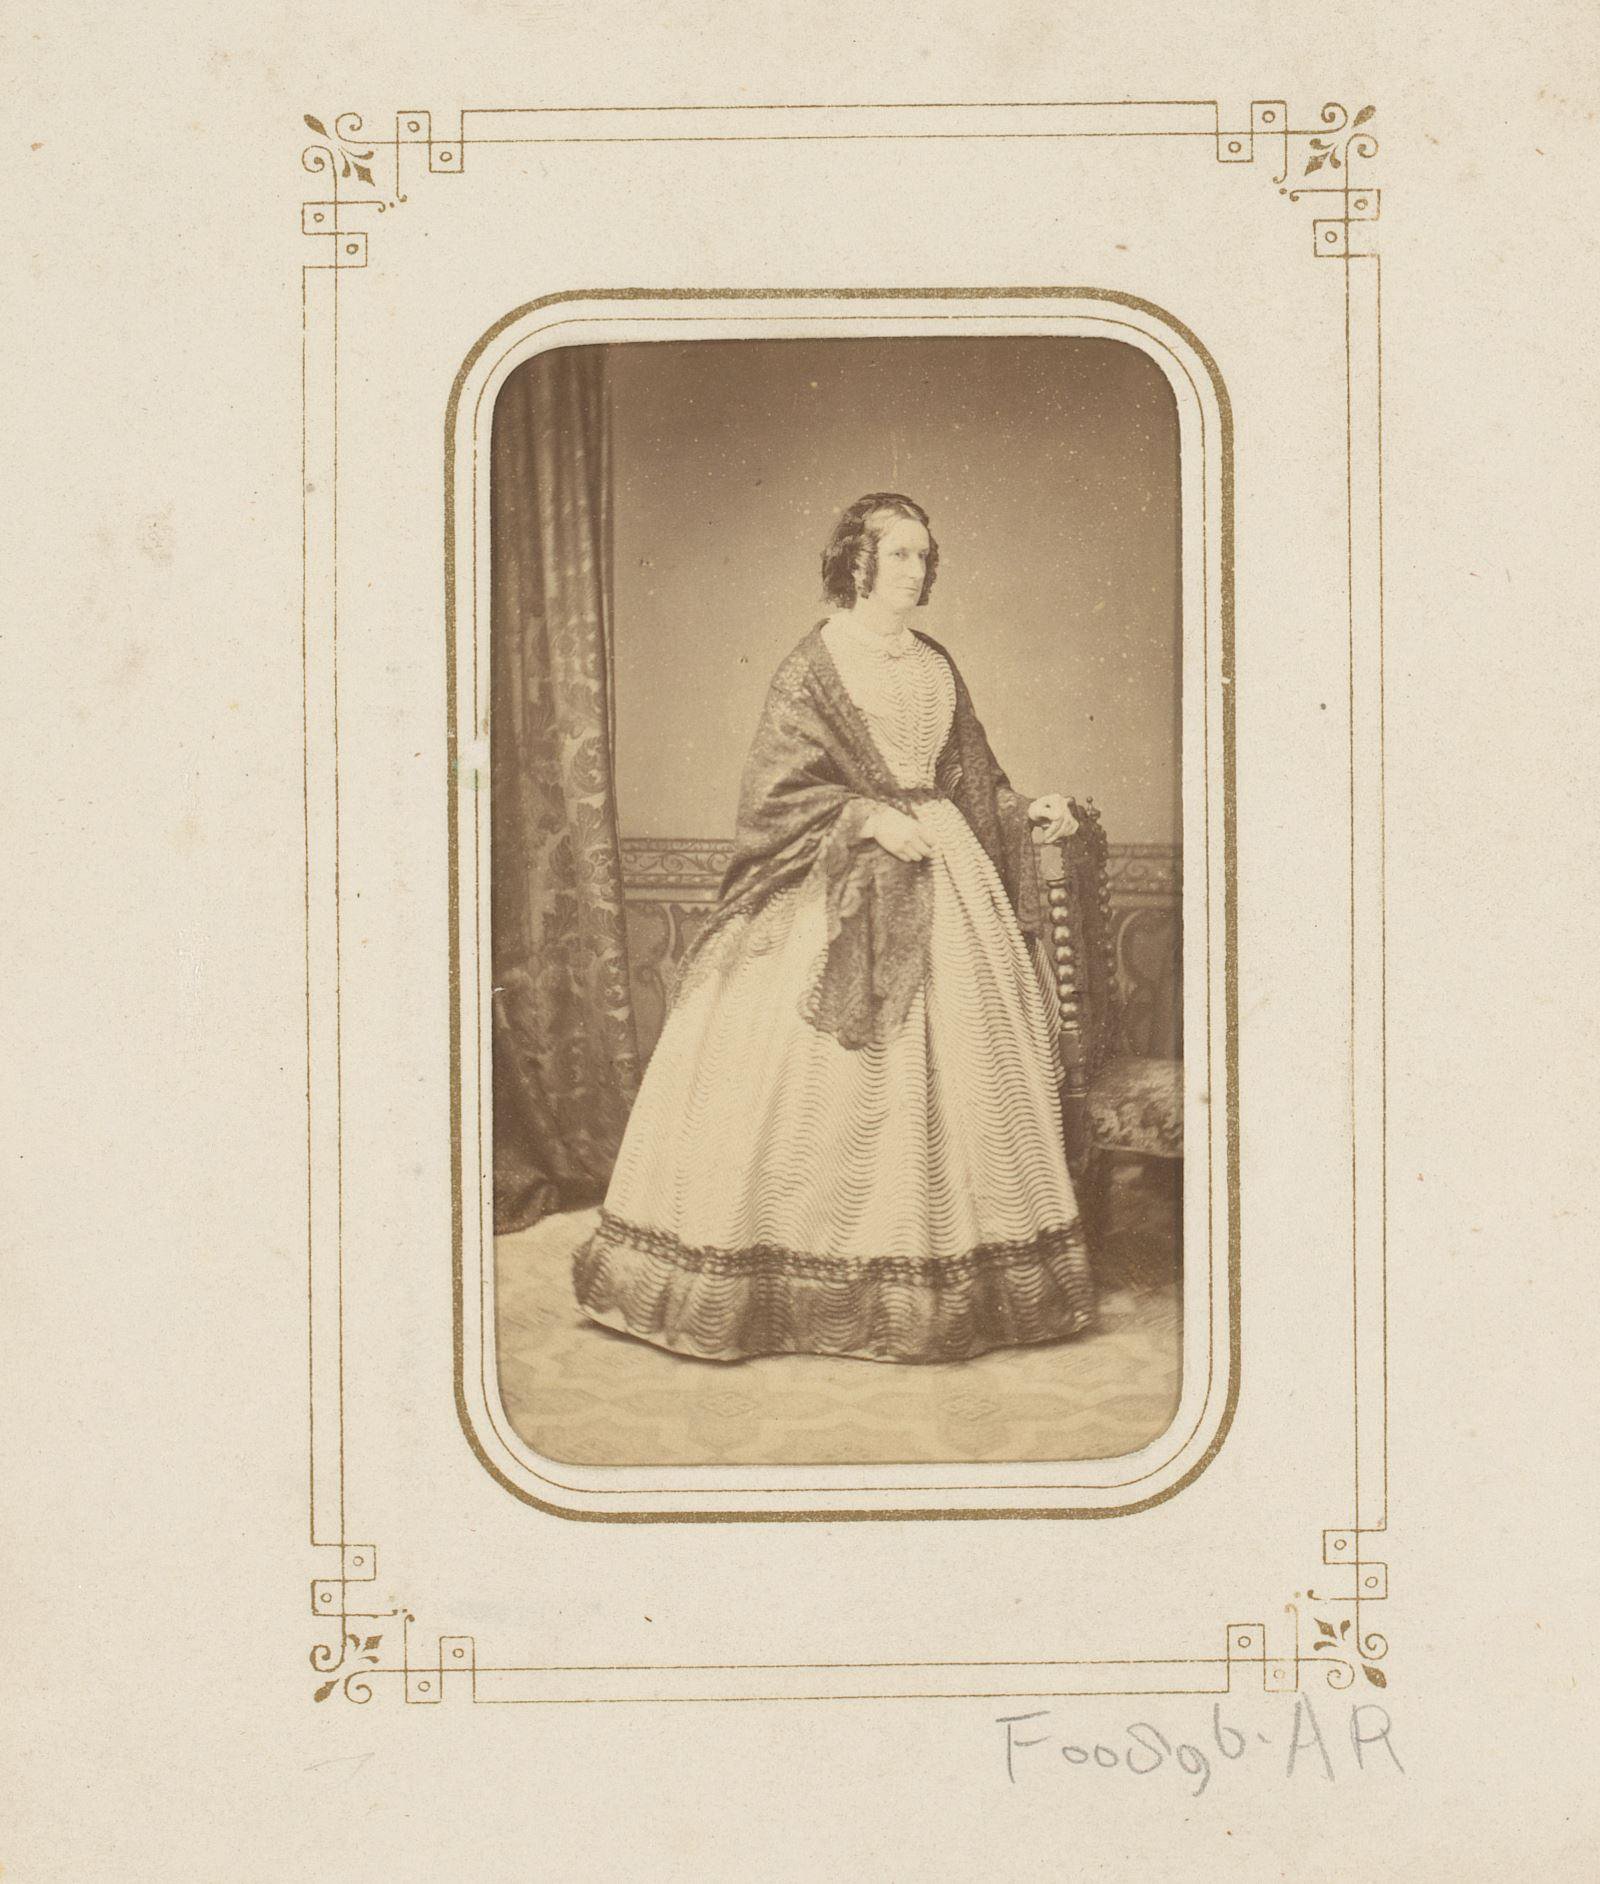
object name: carte de visite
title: Portret van een vrouw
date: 1855-1890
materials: cardboard, photographic support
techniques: albumen print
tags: adult woman, historical persons, standing figure - aa - female human figure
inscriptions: inscription: ‘[...] verso 103 Newcate St., 174 Regent St., [...]’